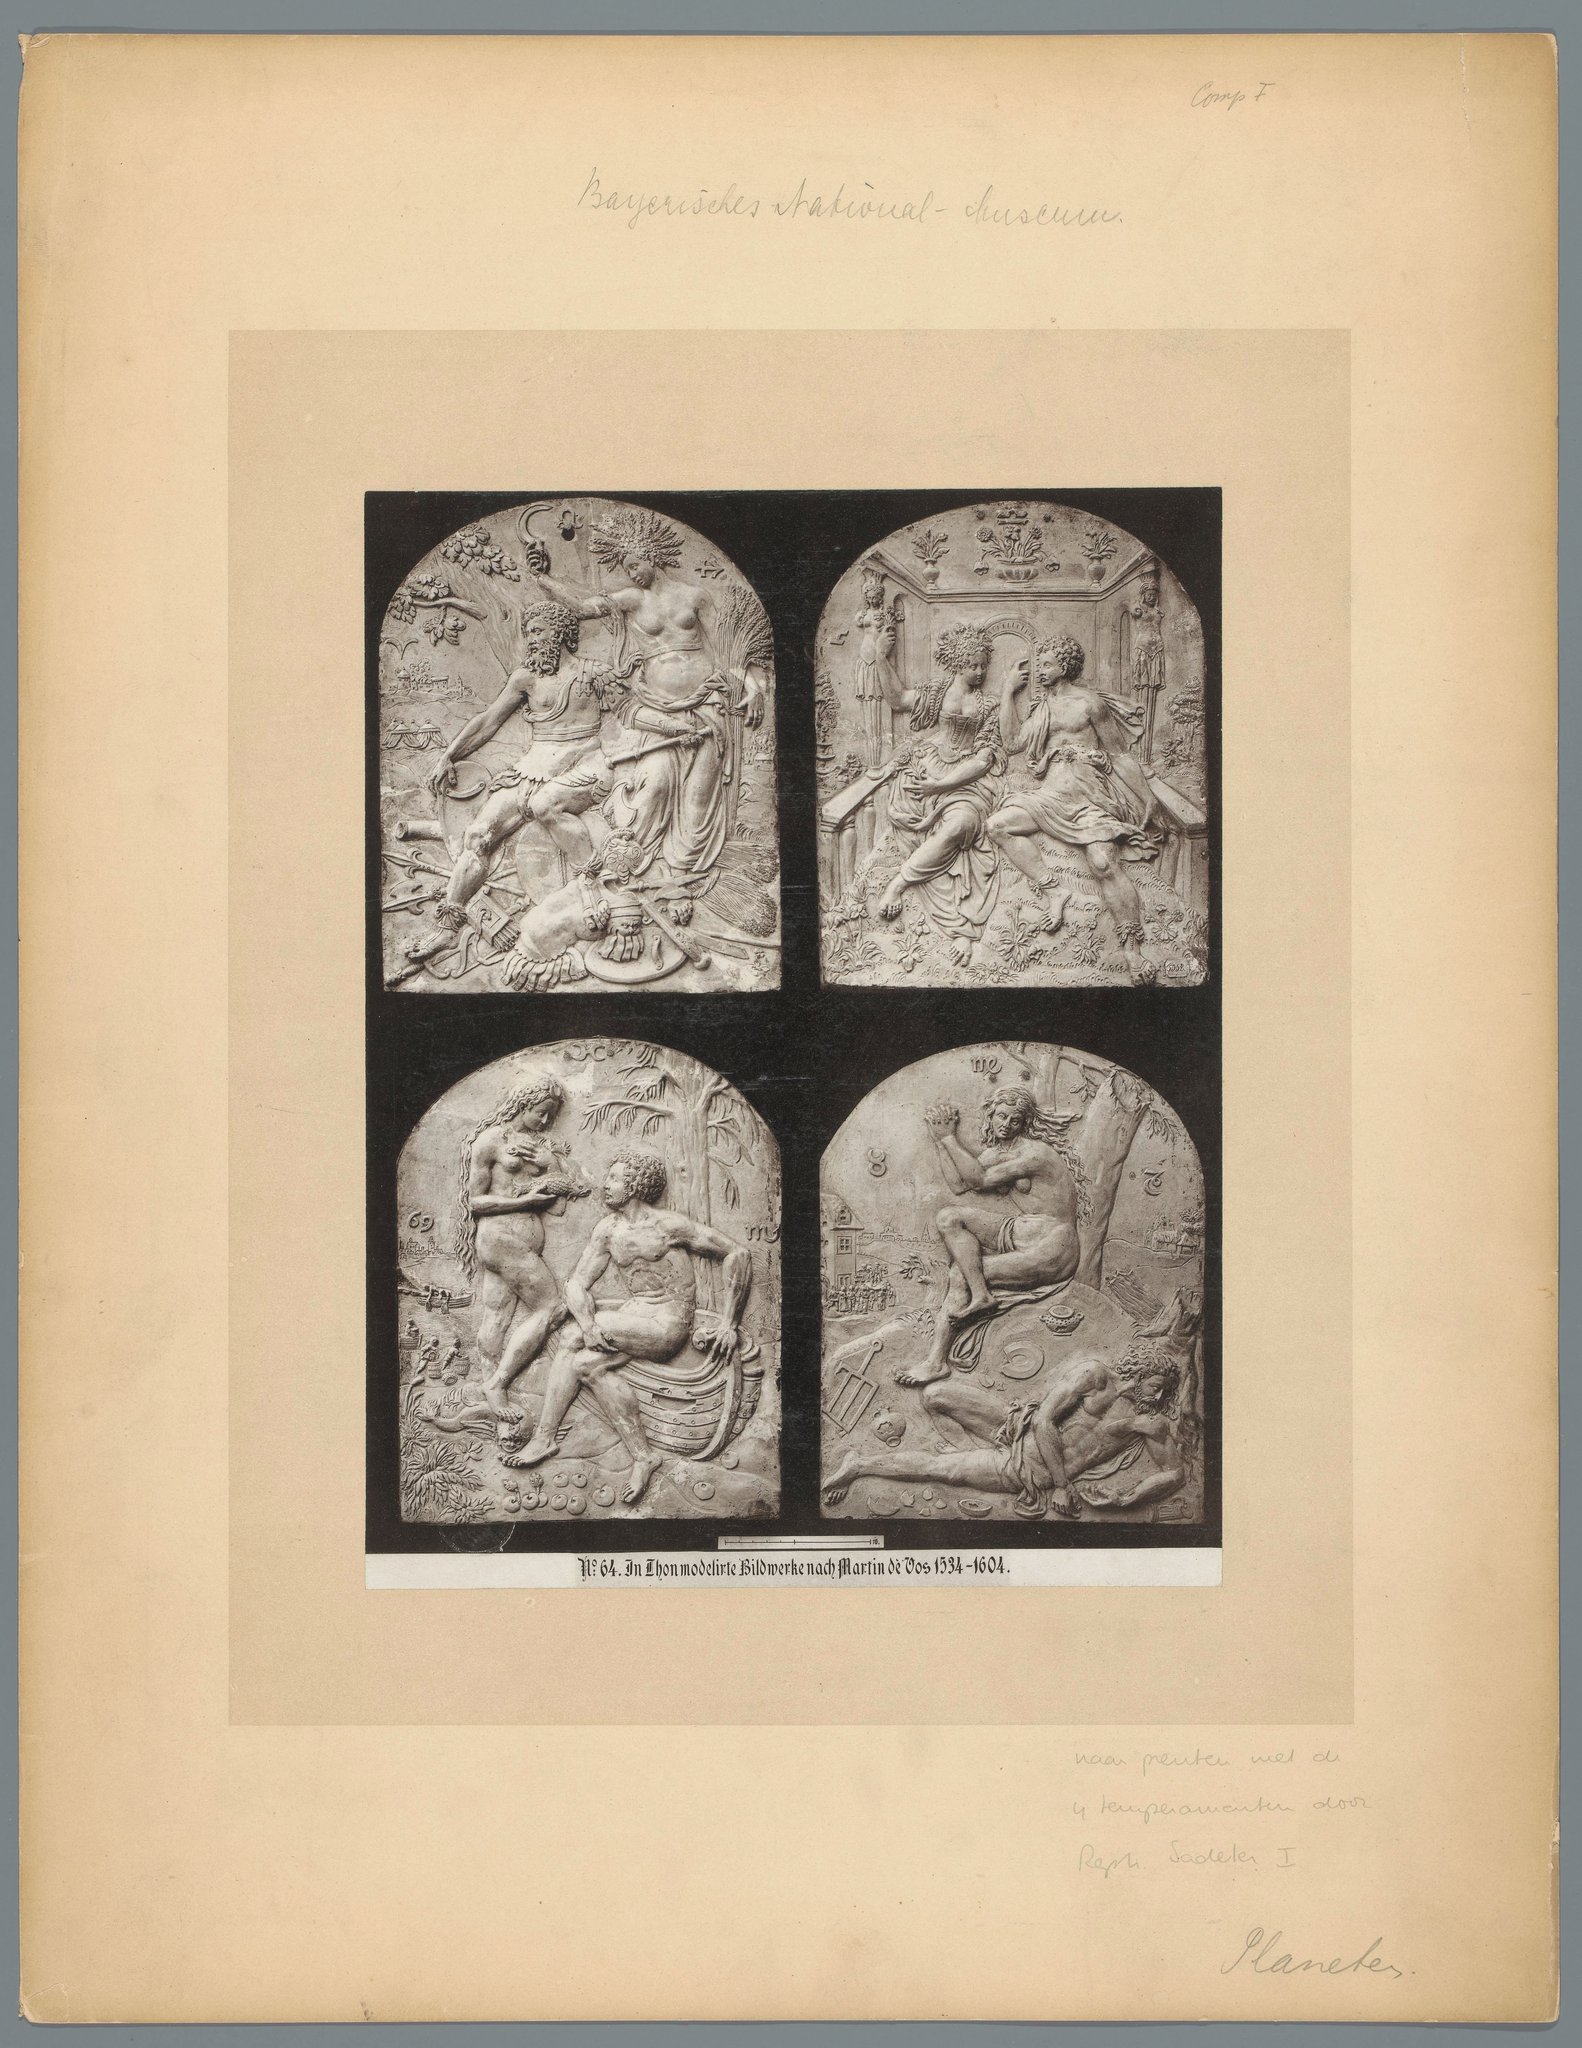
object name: photograph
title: Vier reliëfs met de temperamenten naar prenten van Marten de Vos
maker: Anonymous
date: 1875-1900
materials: cardboard, paper, ink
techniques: photograph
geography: europe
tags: 32a1 the four temperaments; 'complessione' (ripa), sculpture (+ relief ~ sculpture), europe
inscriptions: collector's mark: Lugt 3937, inscription: ‘naar prenten met de 4 temperamenten door Re[...] Sadelen I Planetes.’, inscription: ‘Ba[...] National Museum’, number: ‘No: 64.’